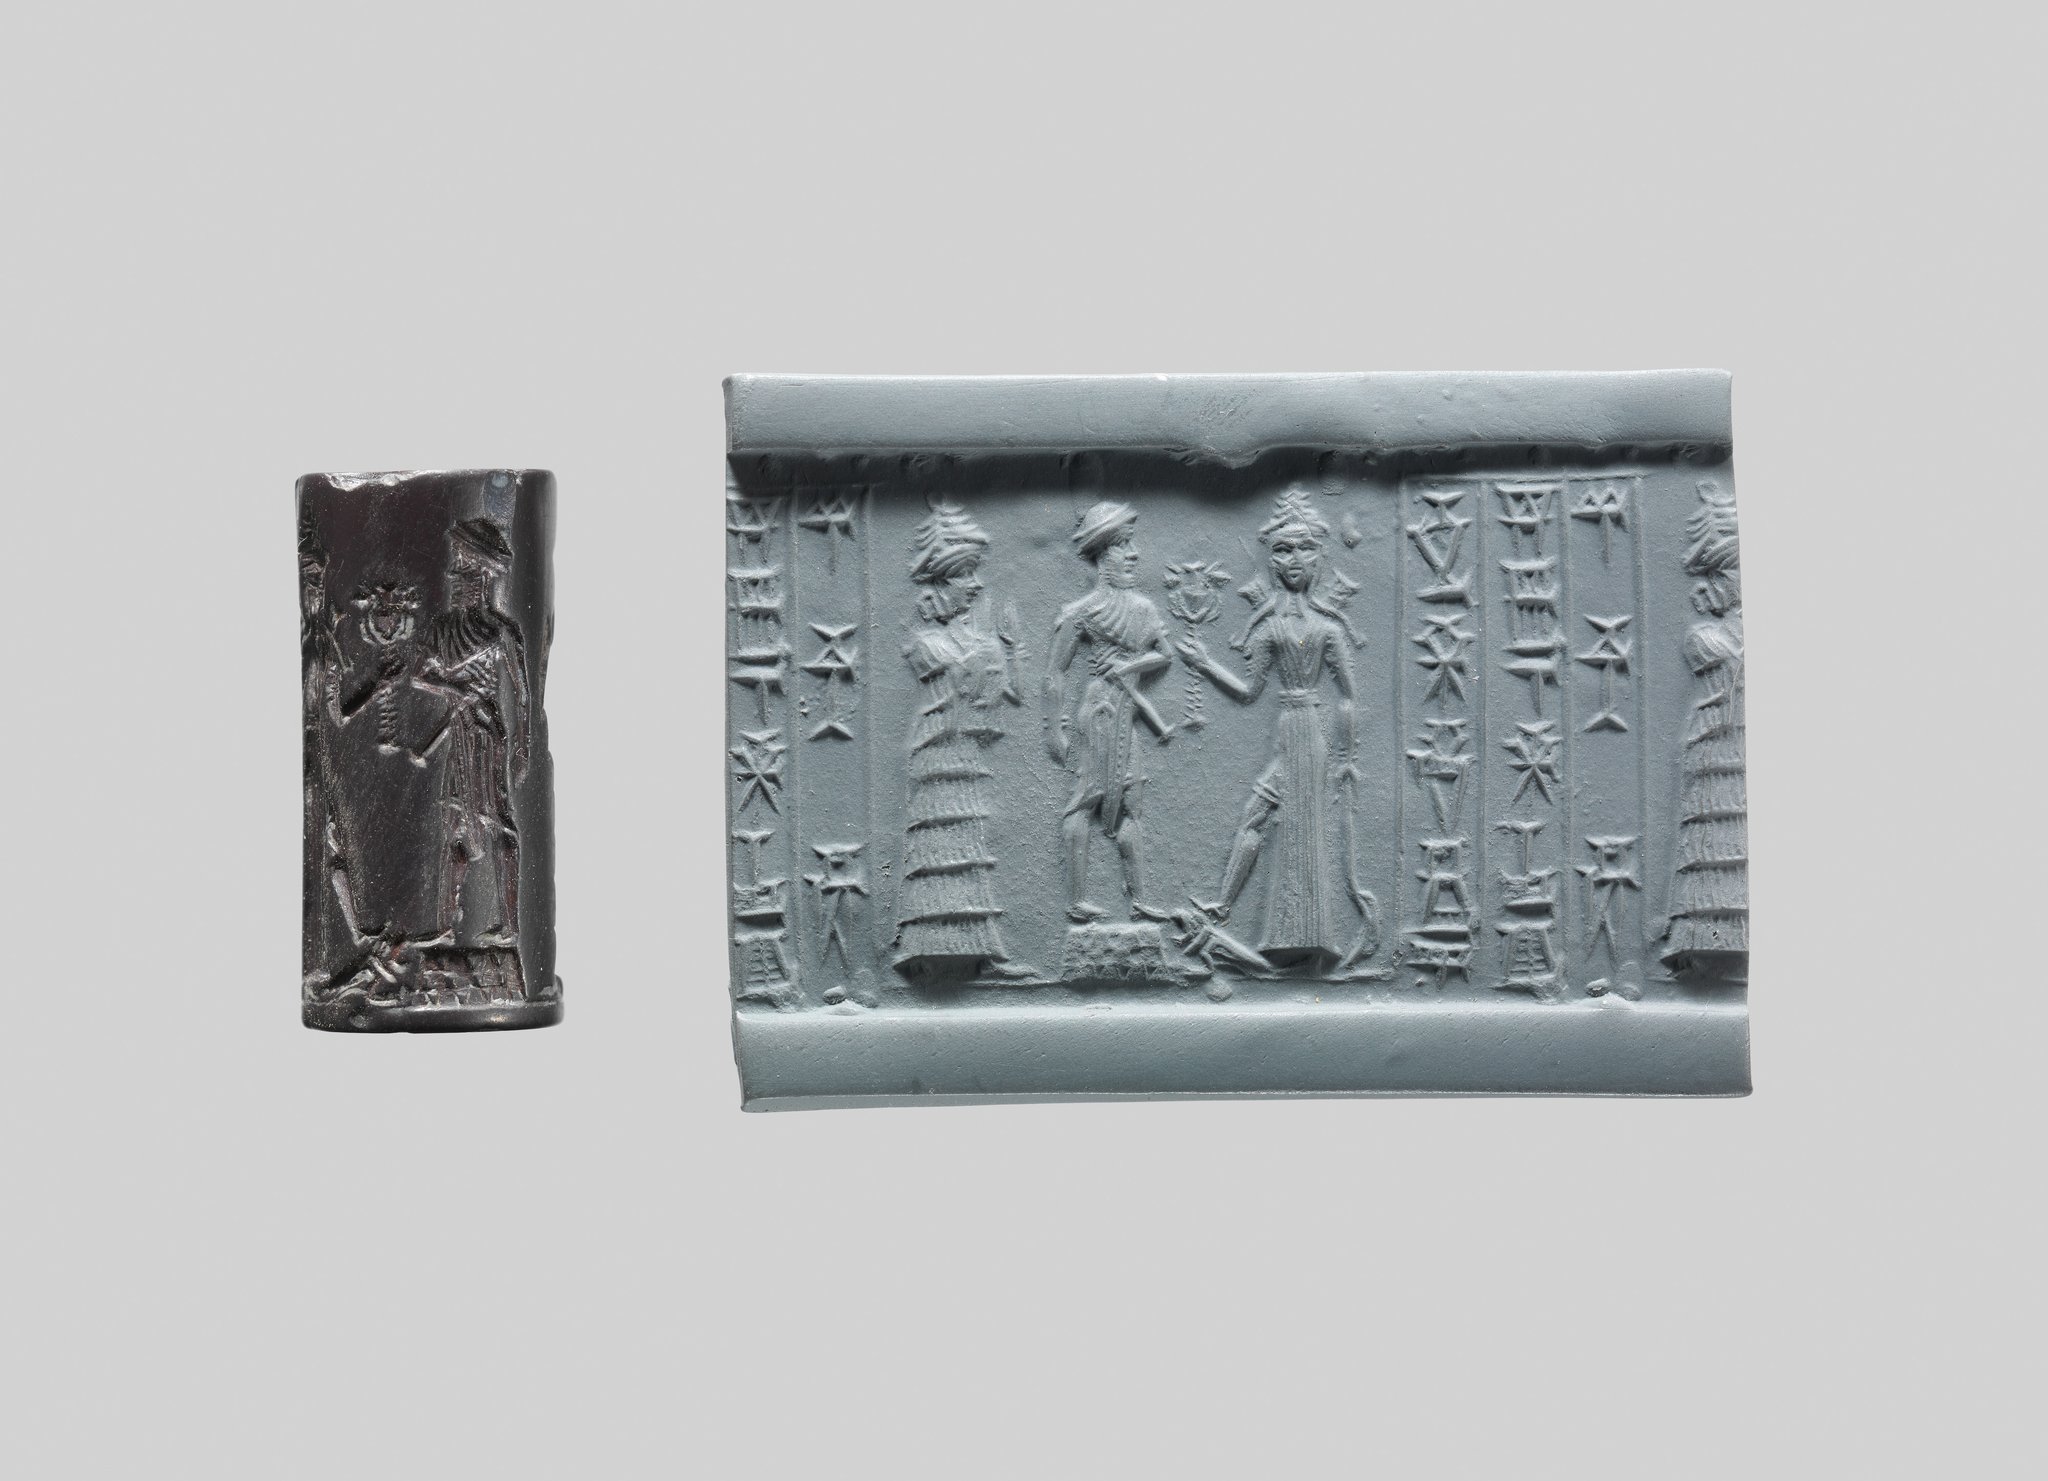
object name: cylinder seal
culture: babylonian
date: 1800-1601 BCE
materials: mineral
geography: mesopotamia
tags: men,goddess